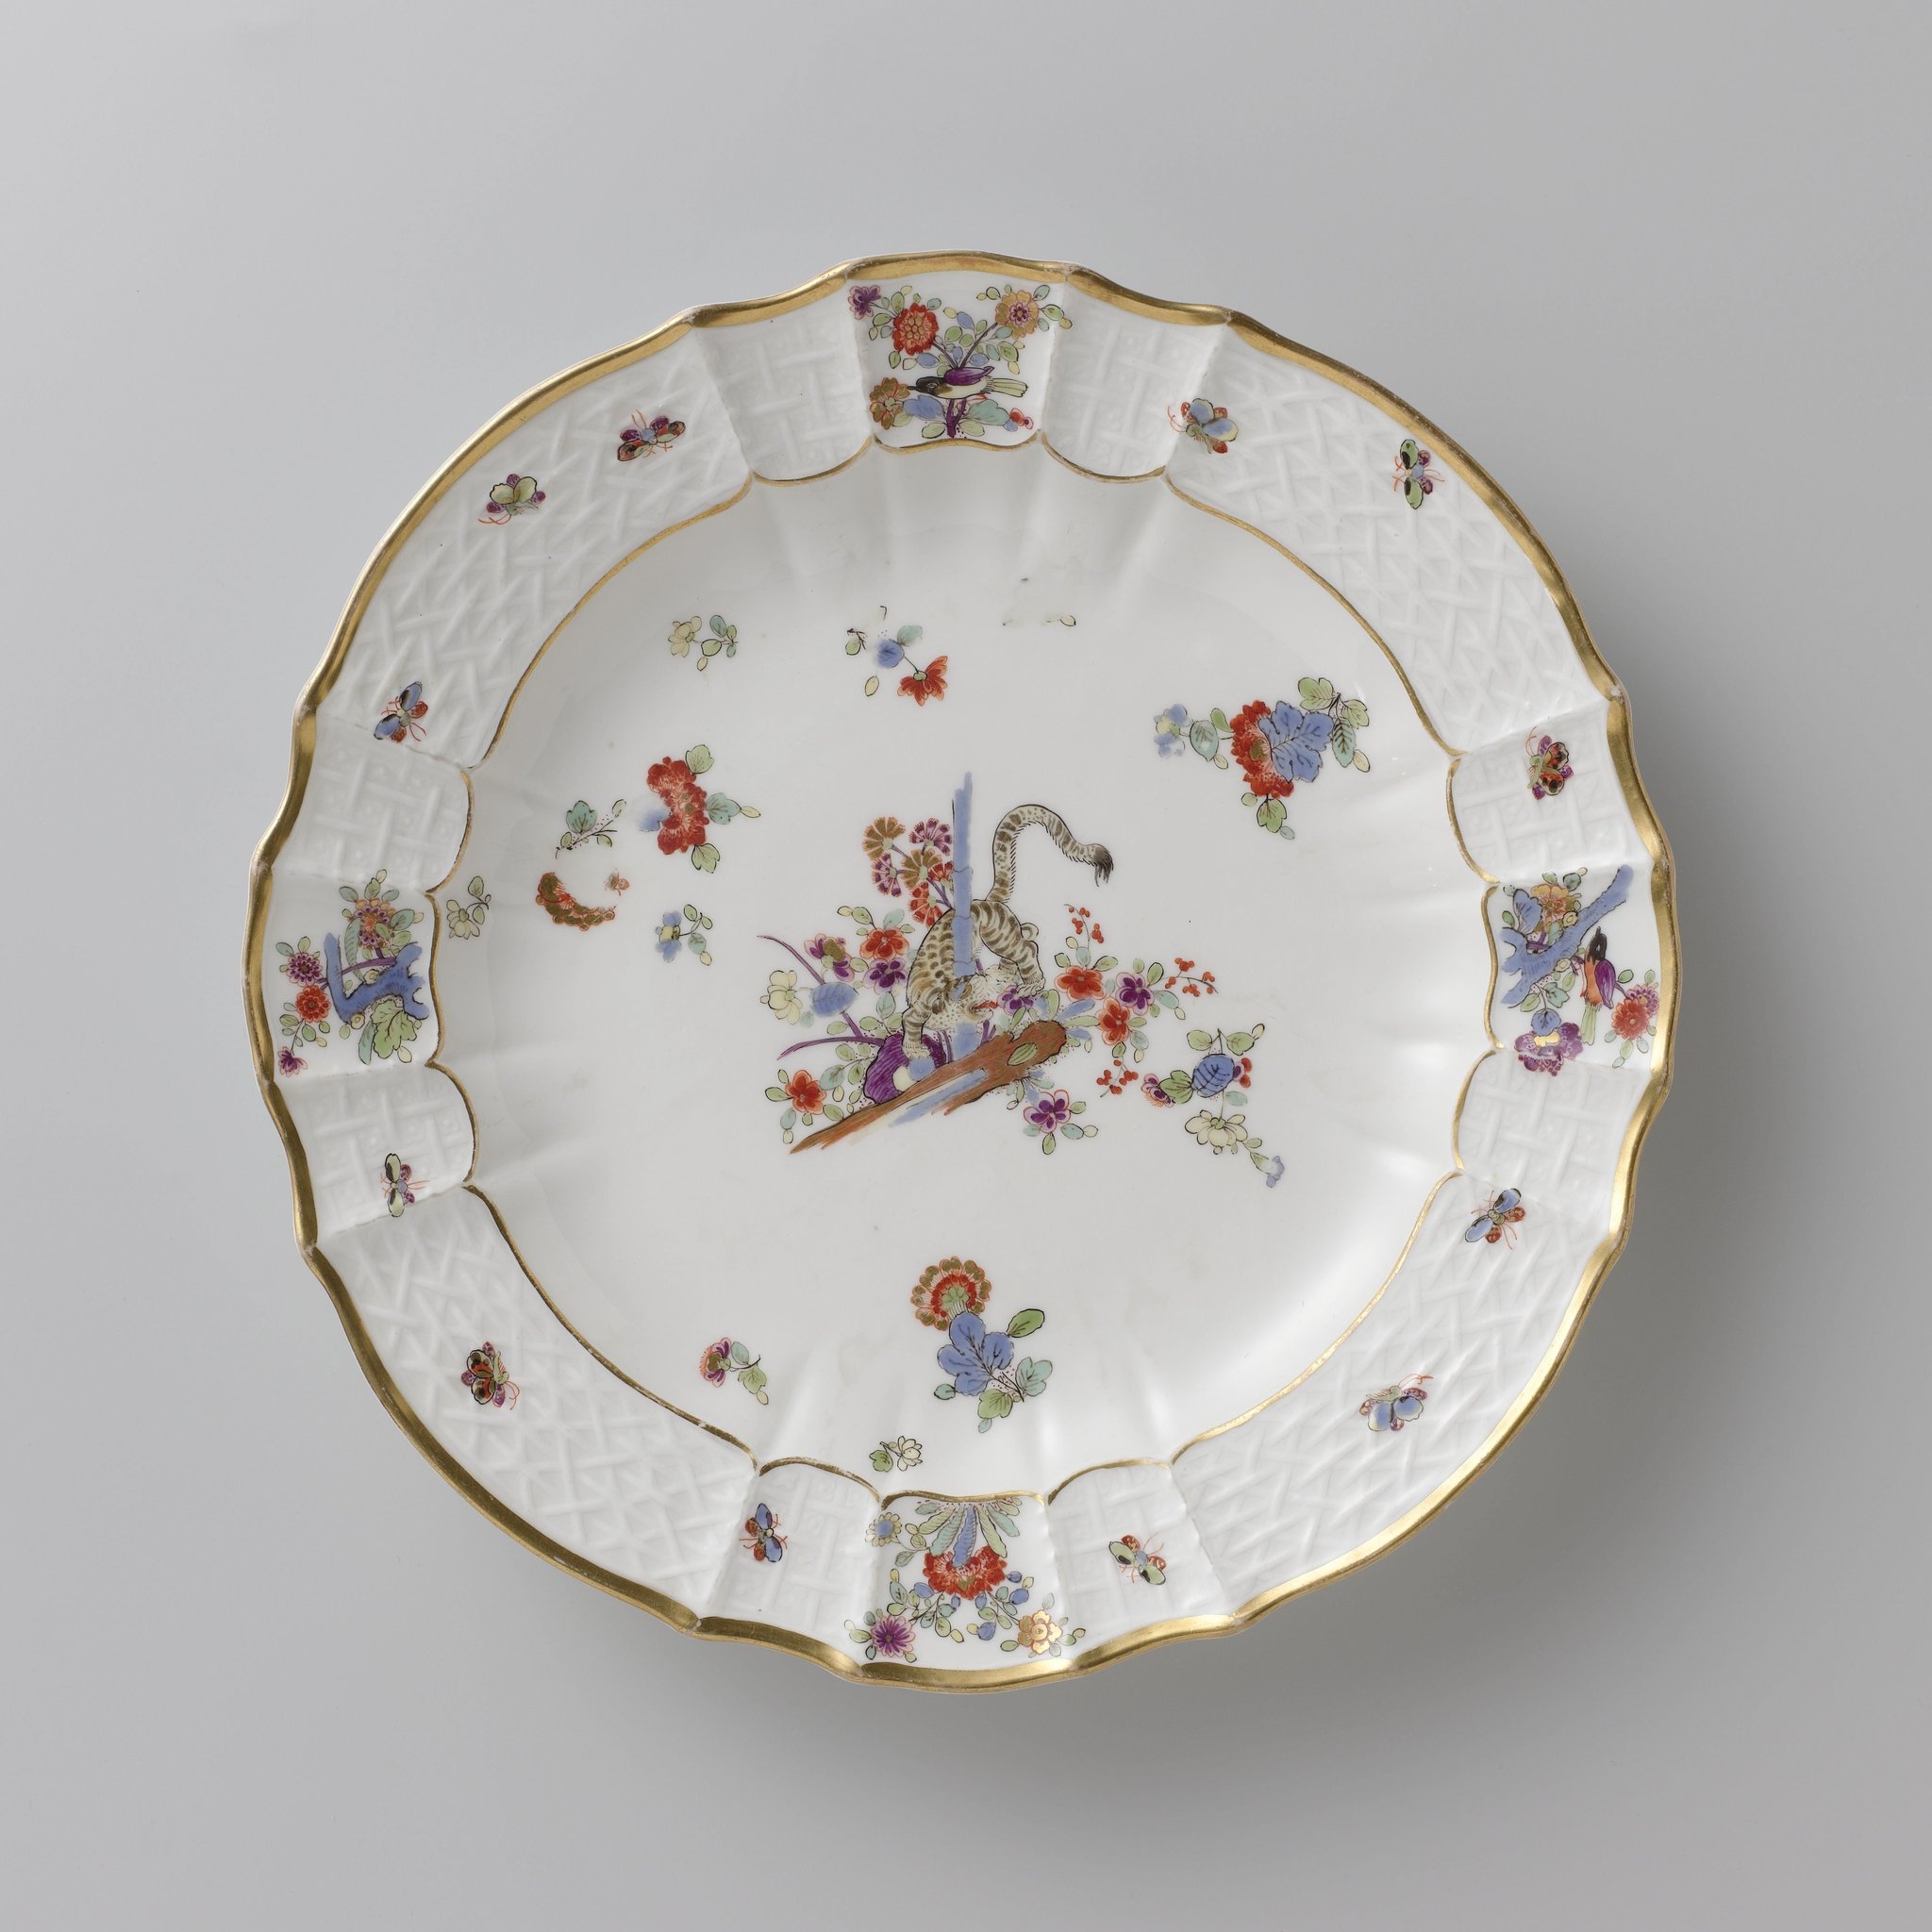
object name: plate dish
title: Rond bord, veelkleurig beschilderd met een Kakiemon-decor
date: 1740-1745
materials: porcelain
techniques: painted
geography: meissen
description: Rond bord van beschilderd porselein. Het bord is geribd en heeft een geschulpte rand. Het bord is beschilderd met een tijger die om een blauwe bamboestengel tussen bloemen is gedraaid, gestrooide Indianische Blumen, vlinders en takken waarop vogels. De rand is versierd met het 'Altbrandenstein'-patroon. Het bord is gemerkt.